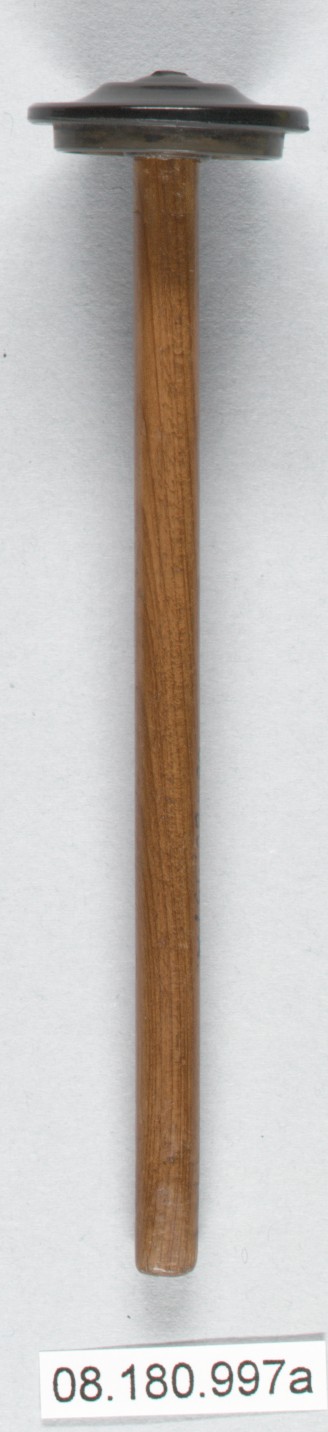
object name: bobbin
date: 1801-1900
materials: wood